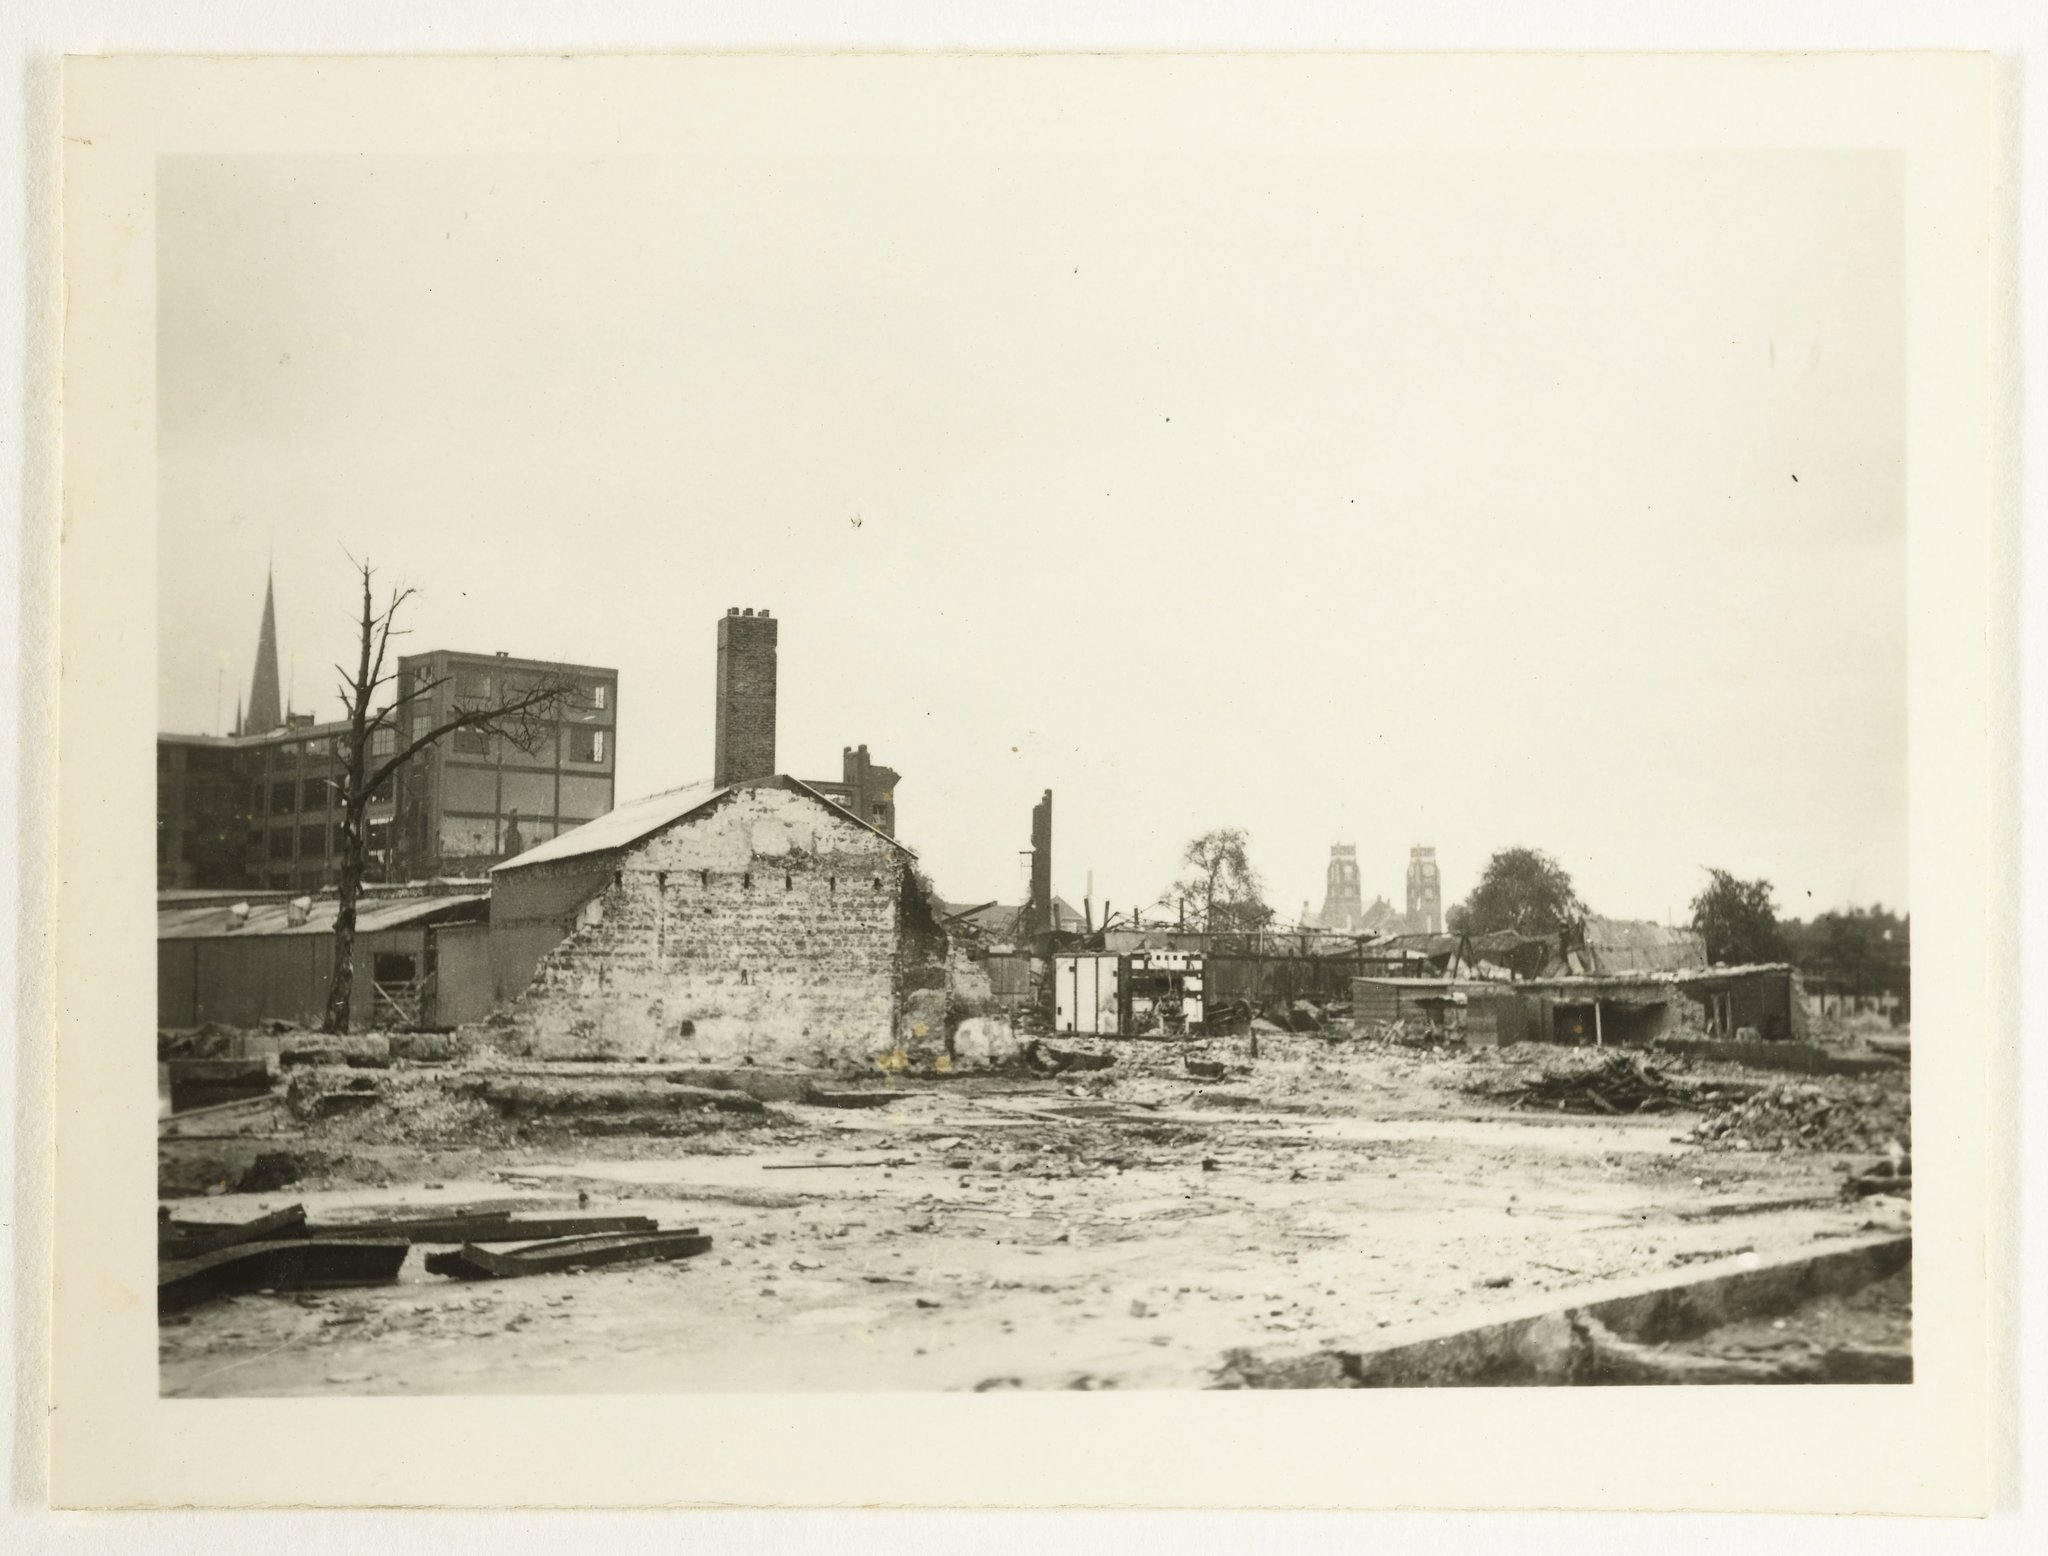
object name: photograph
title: Gebombardeerd Rotterdam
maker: Anonymous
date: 1909-1940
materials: photographic support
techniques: gelatin silver print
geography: rotterdam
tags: devastated, ruined place or city (~ warfare), rotterdam, rotterdam blitz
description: Rotterdam enige maanden na het bombardement. Op achterzijde staat: Rotterdam im Sept. 1940